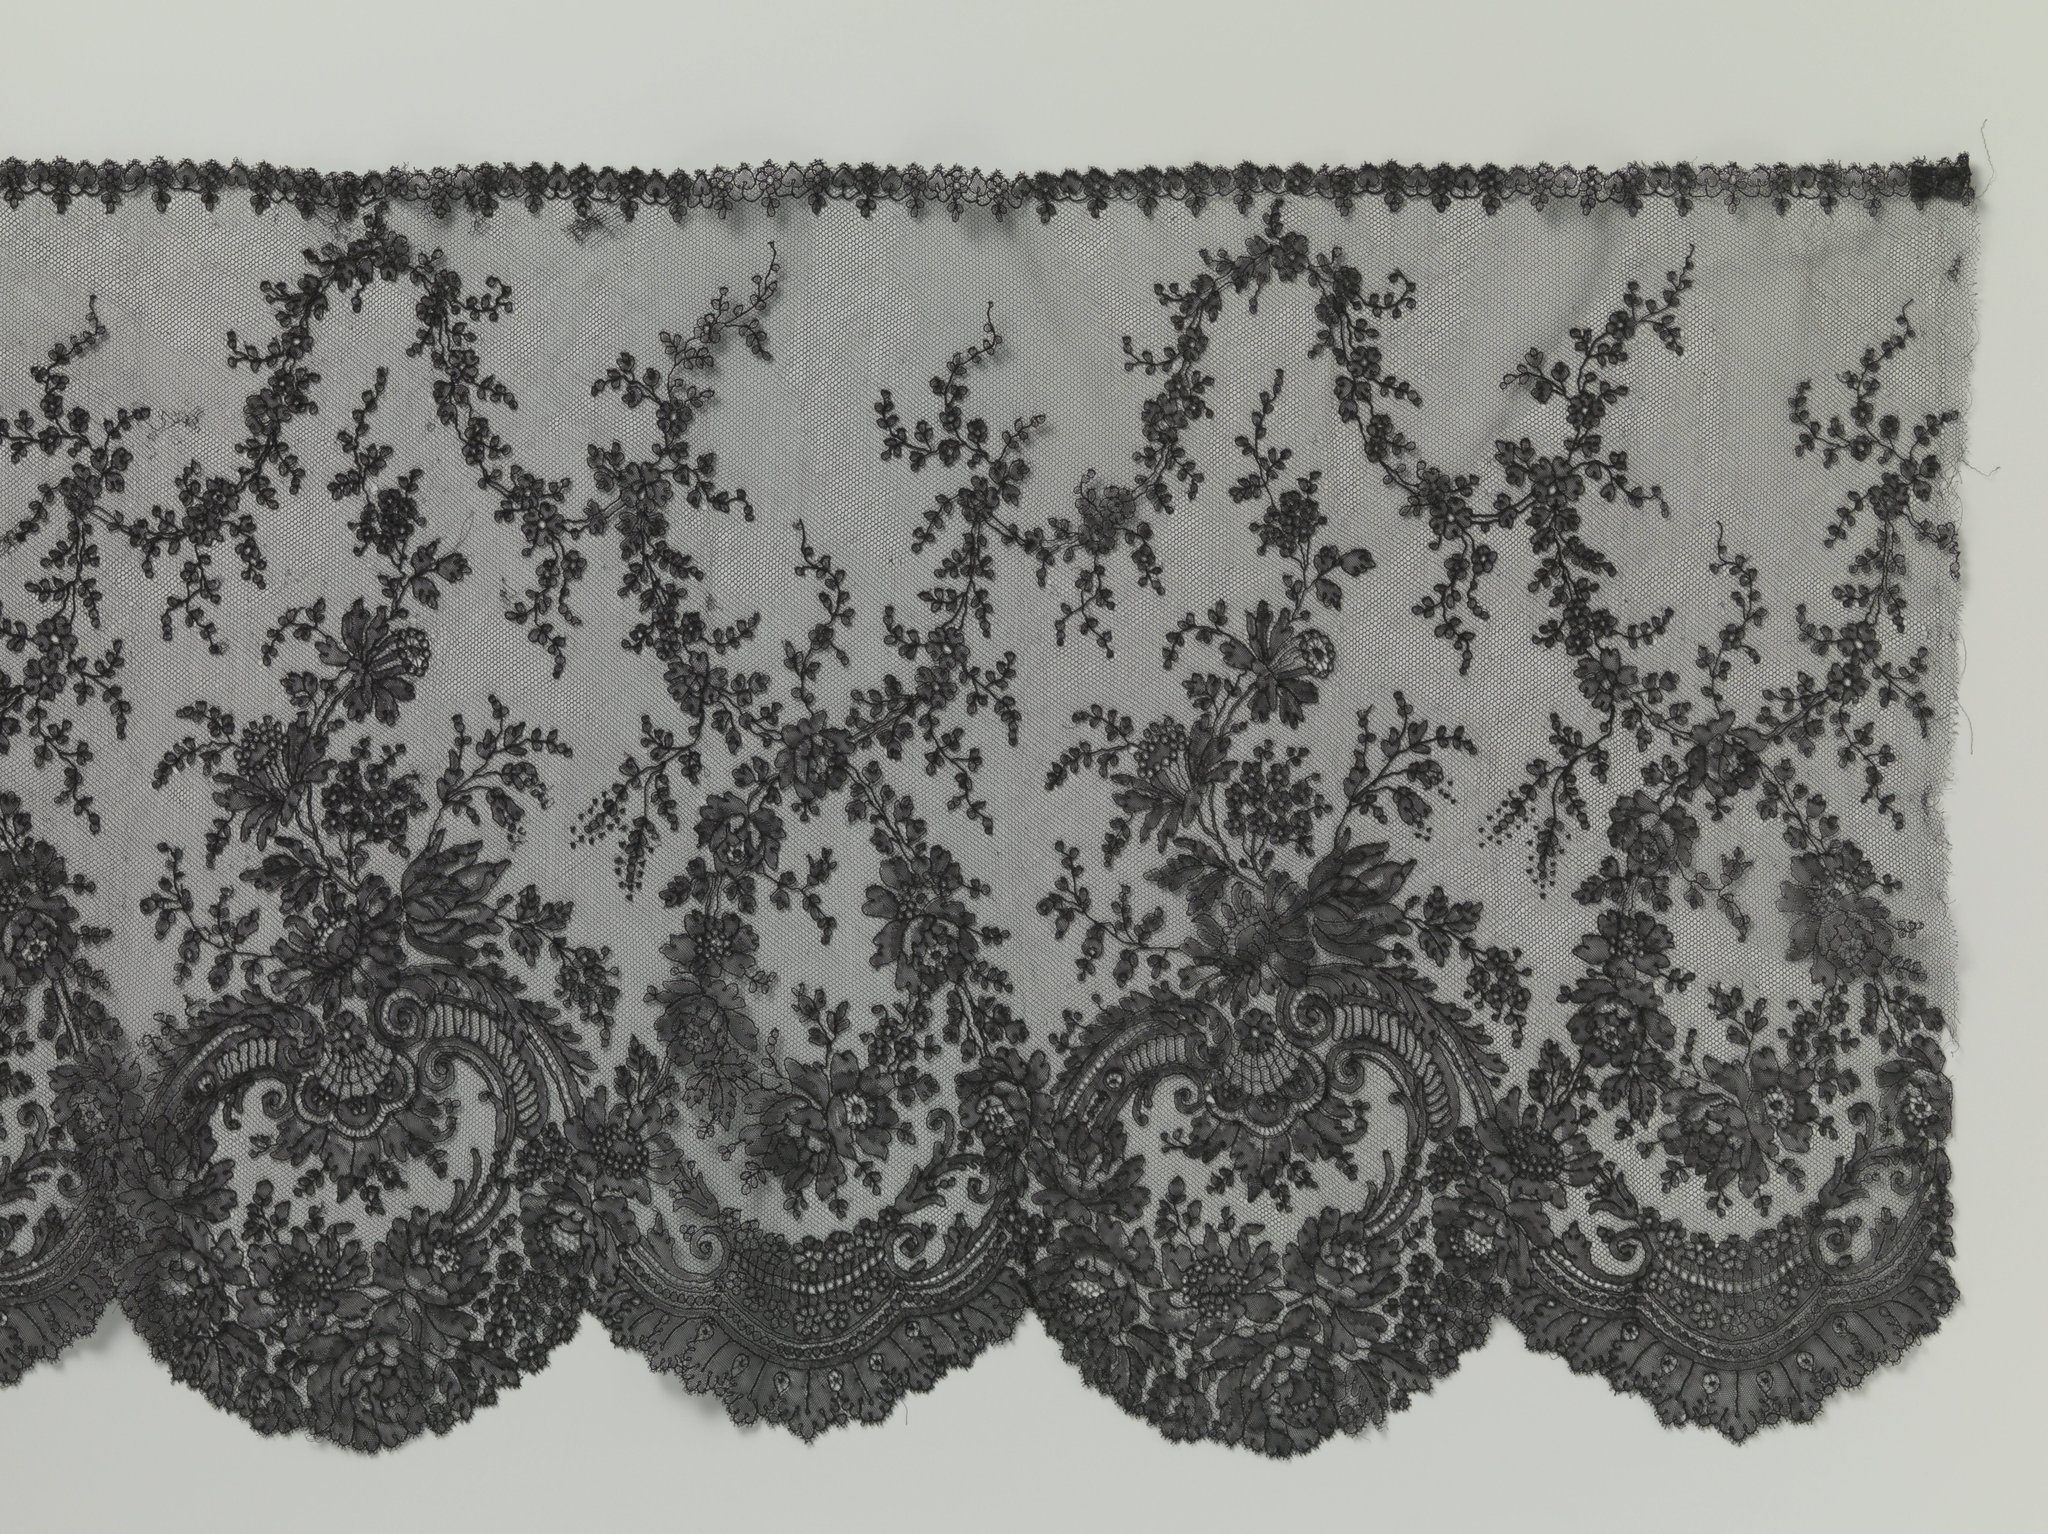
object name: strip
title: Volant van kloskant met toegewende s-voluten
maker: Anonymous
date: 1850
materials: silk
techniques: lace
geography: france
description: Volant van zwarte kloskant: Chantilly-kant. Op een mazenfond staat een bijna symmetrisch patroon van grote, per paar toegewende s-sen, die door zwarte bloemguirlandes worden oversneden. De schulpen zijn half cirkelvormig en afwisselend gevuld met de genoemde guirlande en met een blaadjesrand. Boven de toppen der s-sen staat een losse tak met anemoon, tulp en narcissen. Boven de tweede schulp staat een bloemkrans. De binnenkant en een der zijkanten zijn versierd met een rij van hartjes en bloesems.